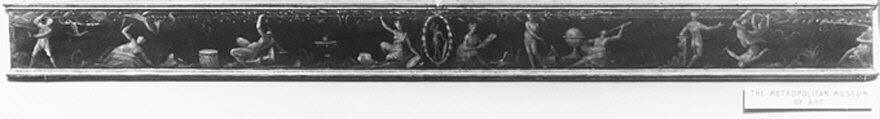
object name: painting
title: Classical design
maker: giovanni da udine (giovanni dei ricamatori)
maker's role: artist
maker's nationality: italian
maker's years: 1487-1564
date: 1401-1600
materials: oil, wood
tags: women